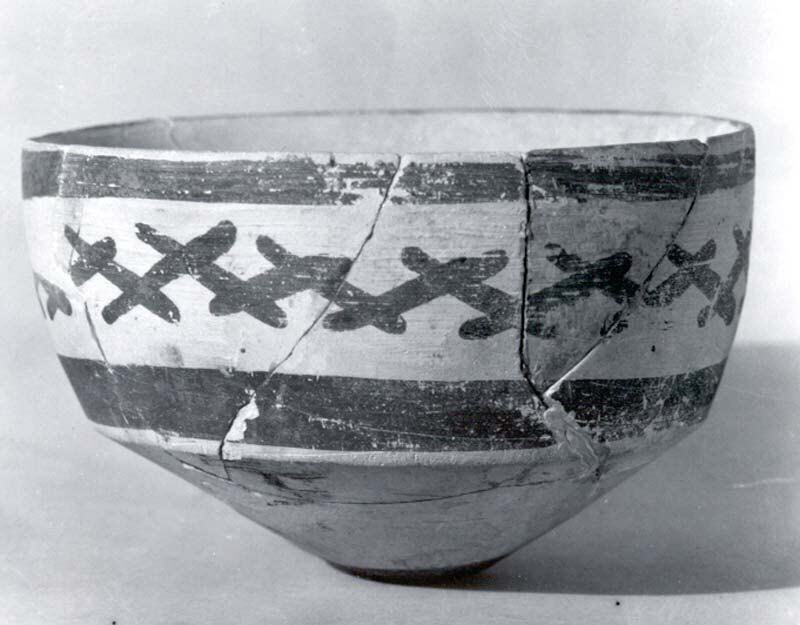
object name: bowl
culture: iranian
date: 4500-4100 BCE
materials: ceramic, paint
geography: iran